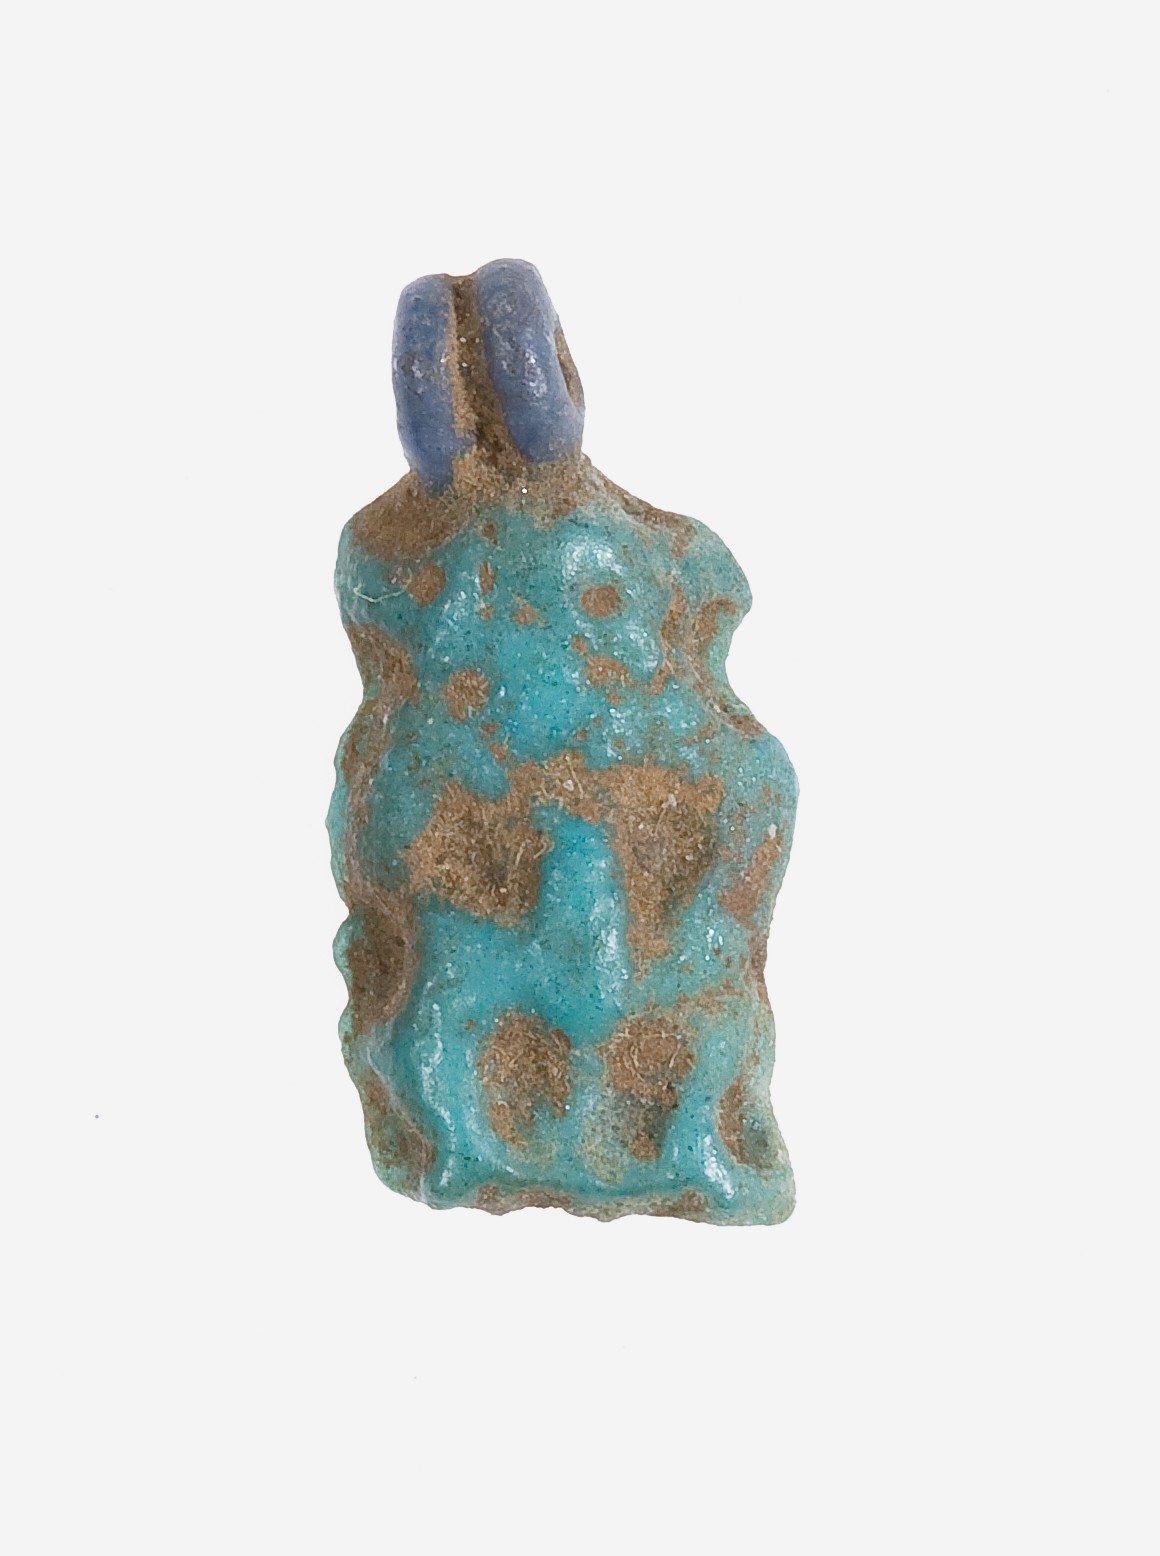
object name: amulet, be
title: Bes Amulet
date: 1390-1352 BCE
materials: faience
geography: egypt